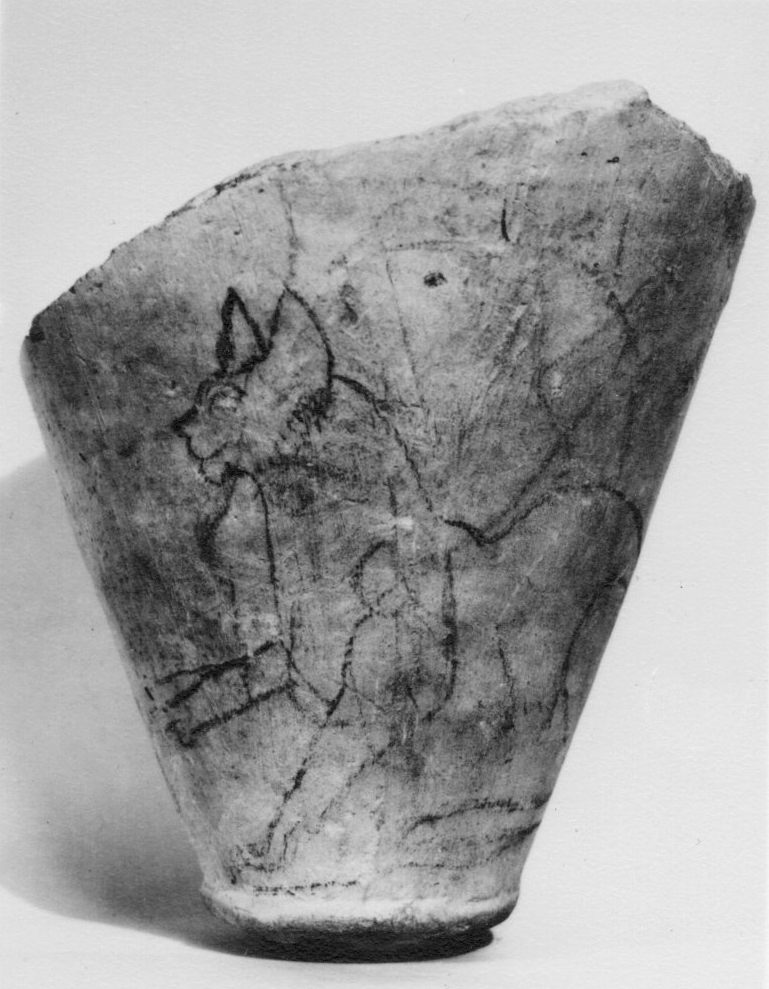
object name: ostracon, figured, cat, king, blue crown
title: Ostracon with the Drawing of a Cat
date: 1390-1352 BCE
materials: charcoal, pottery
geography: egypt